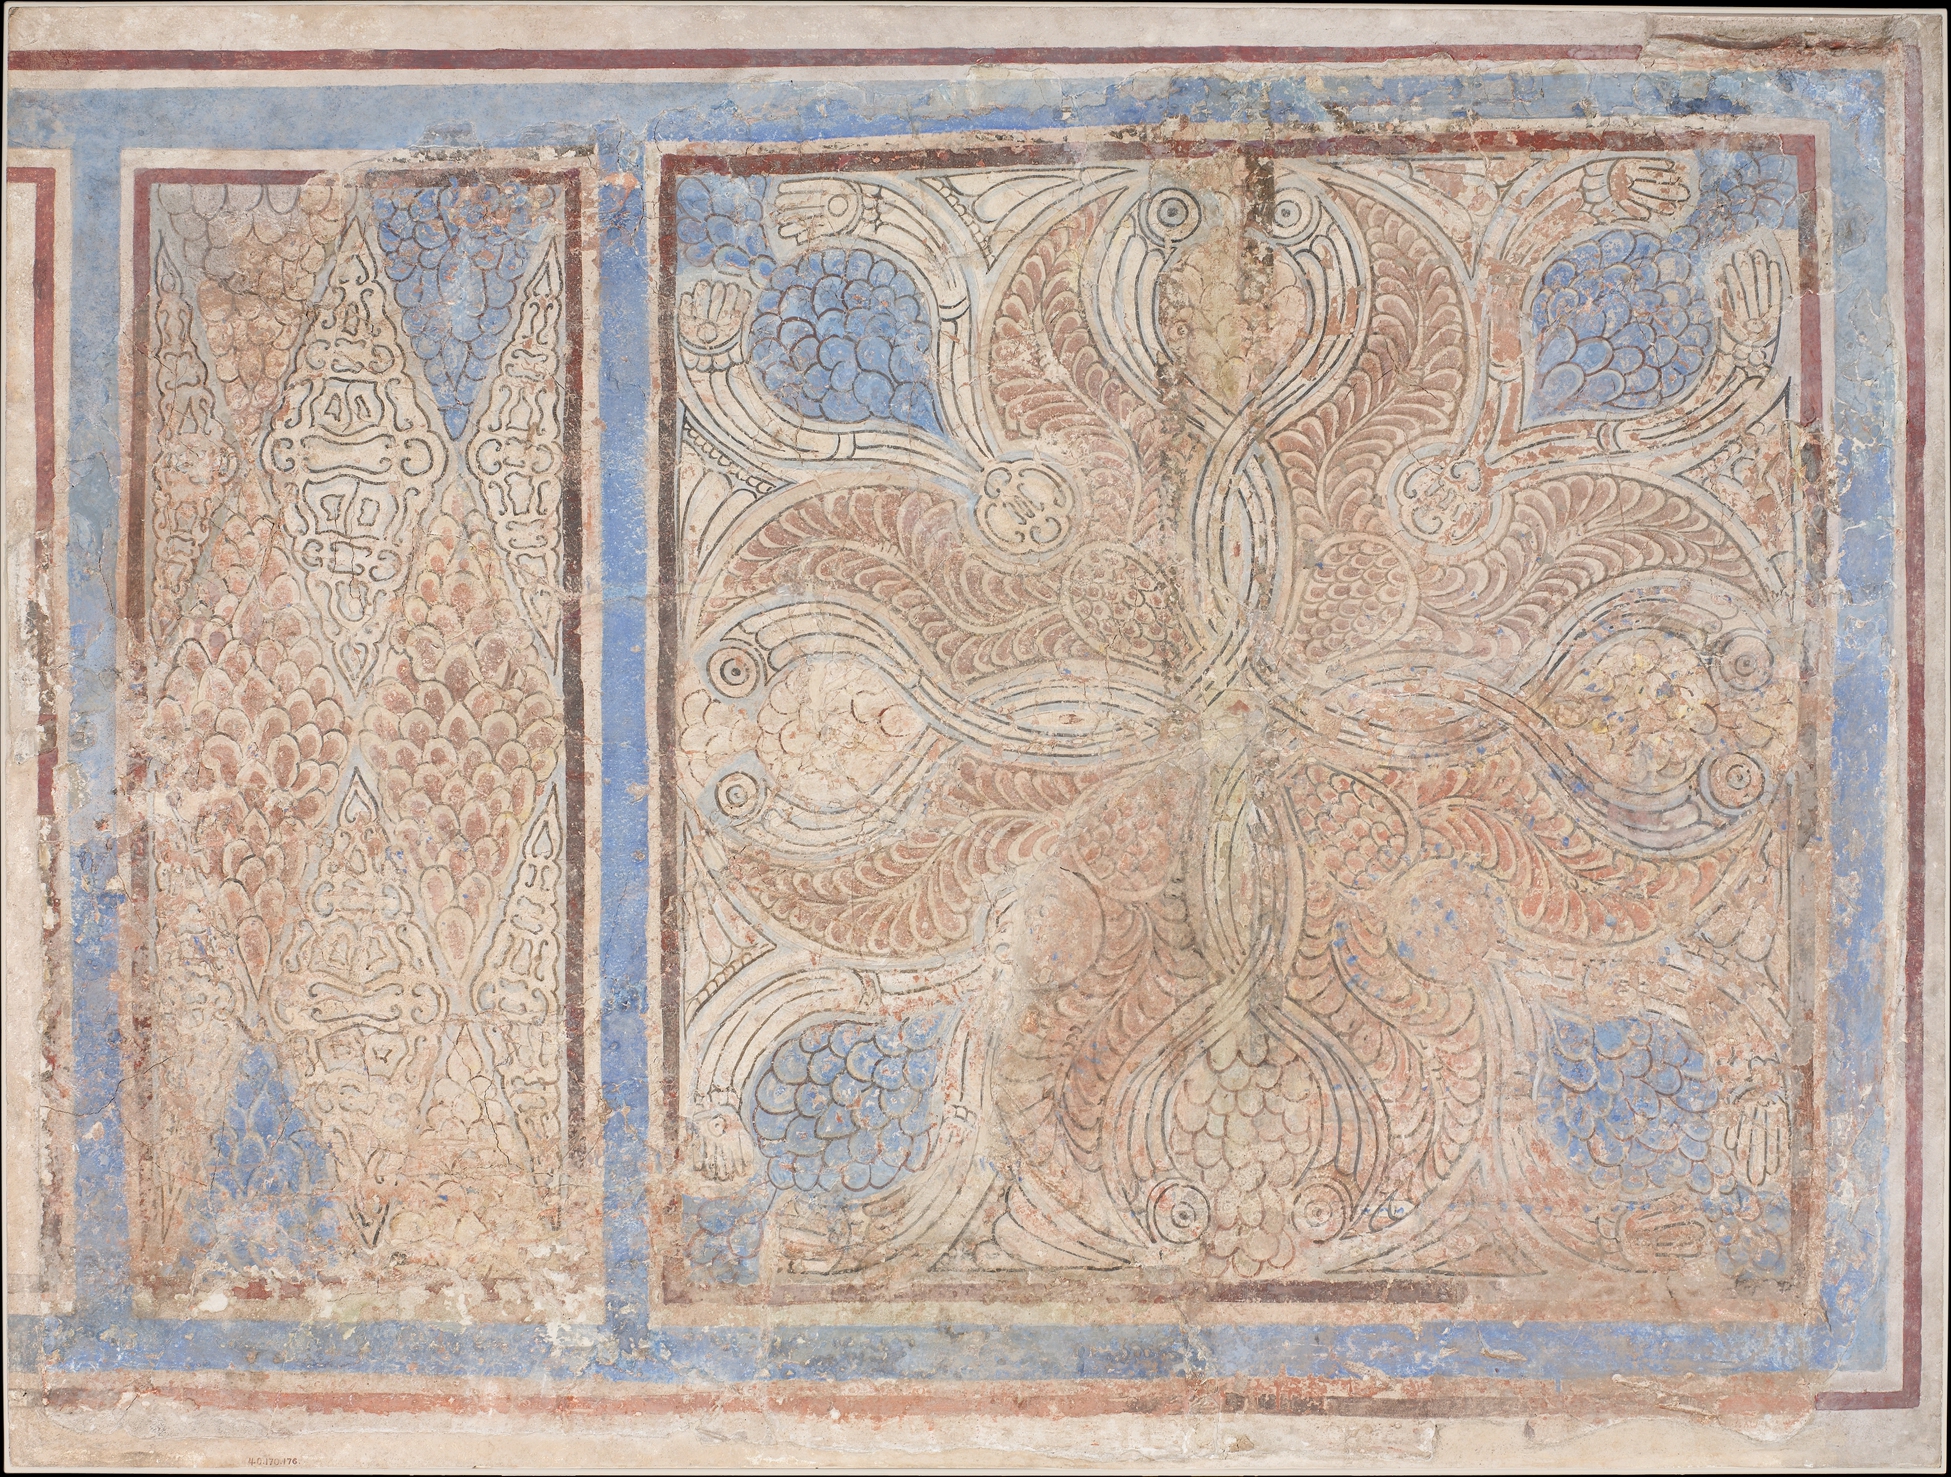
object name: panel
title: Painted Dado Panels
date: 801-900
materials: plaster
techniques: painting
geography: iran